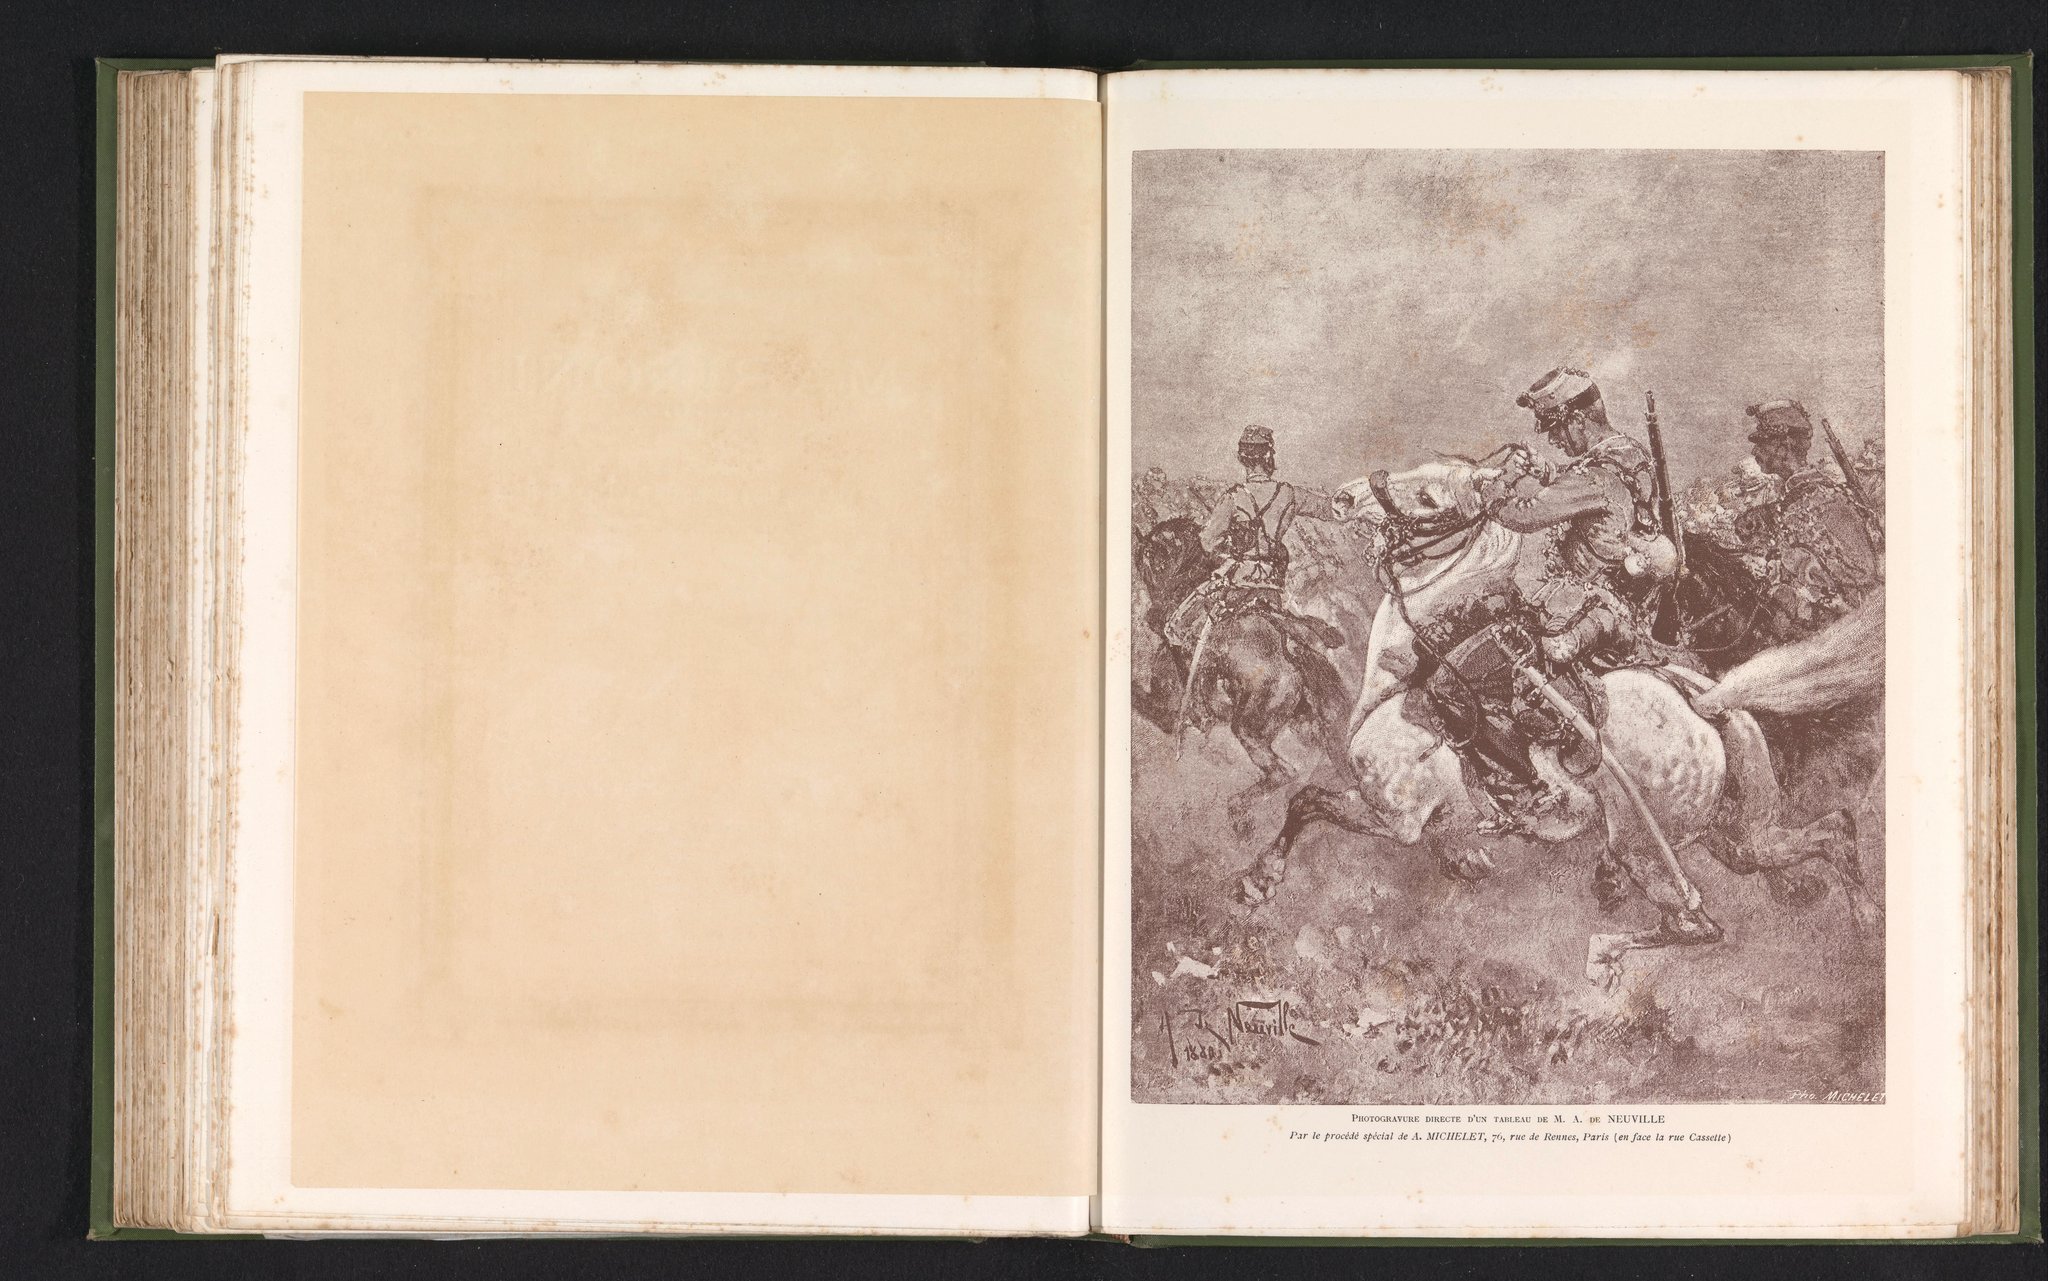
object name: page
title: Fotoreproductie van een schilderij, voorstellende soldaten te paard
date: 1880-1881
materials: paper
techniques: autotype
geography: paris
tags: riding a horse, ass, or mule; rider, horseman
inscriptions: inscription: ‘Par le procédé spécial de A. Michelet, 76, rue de Rennes, Paris (en face la rue Cassette)’